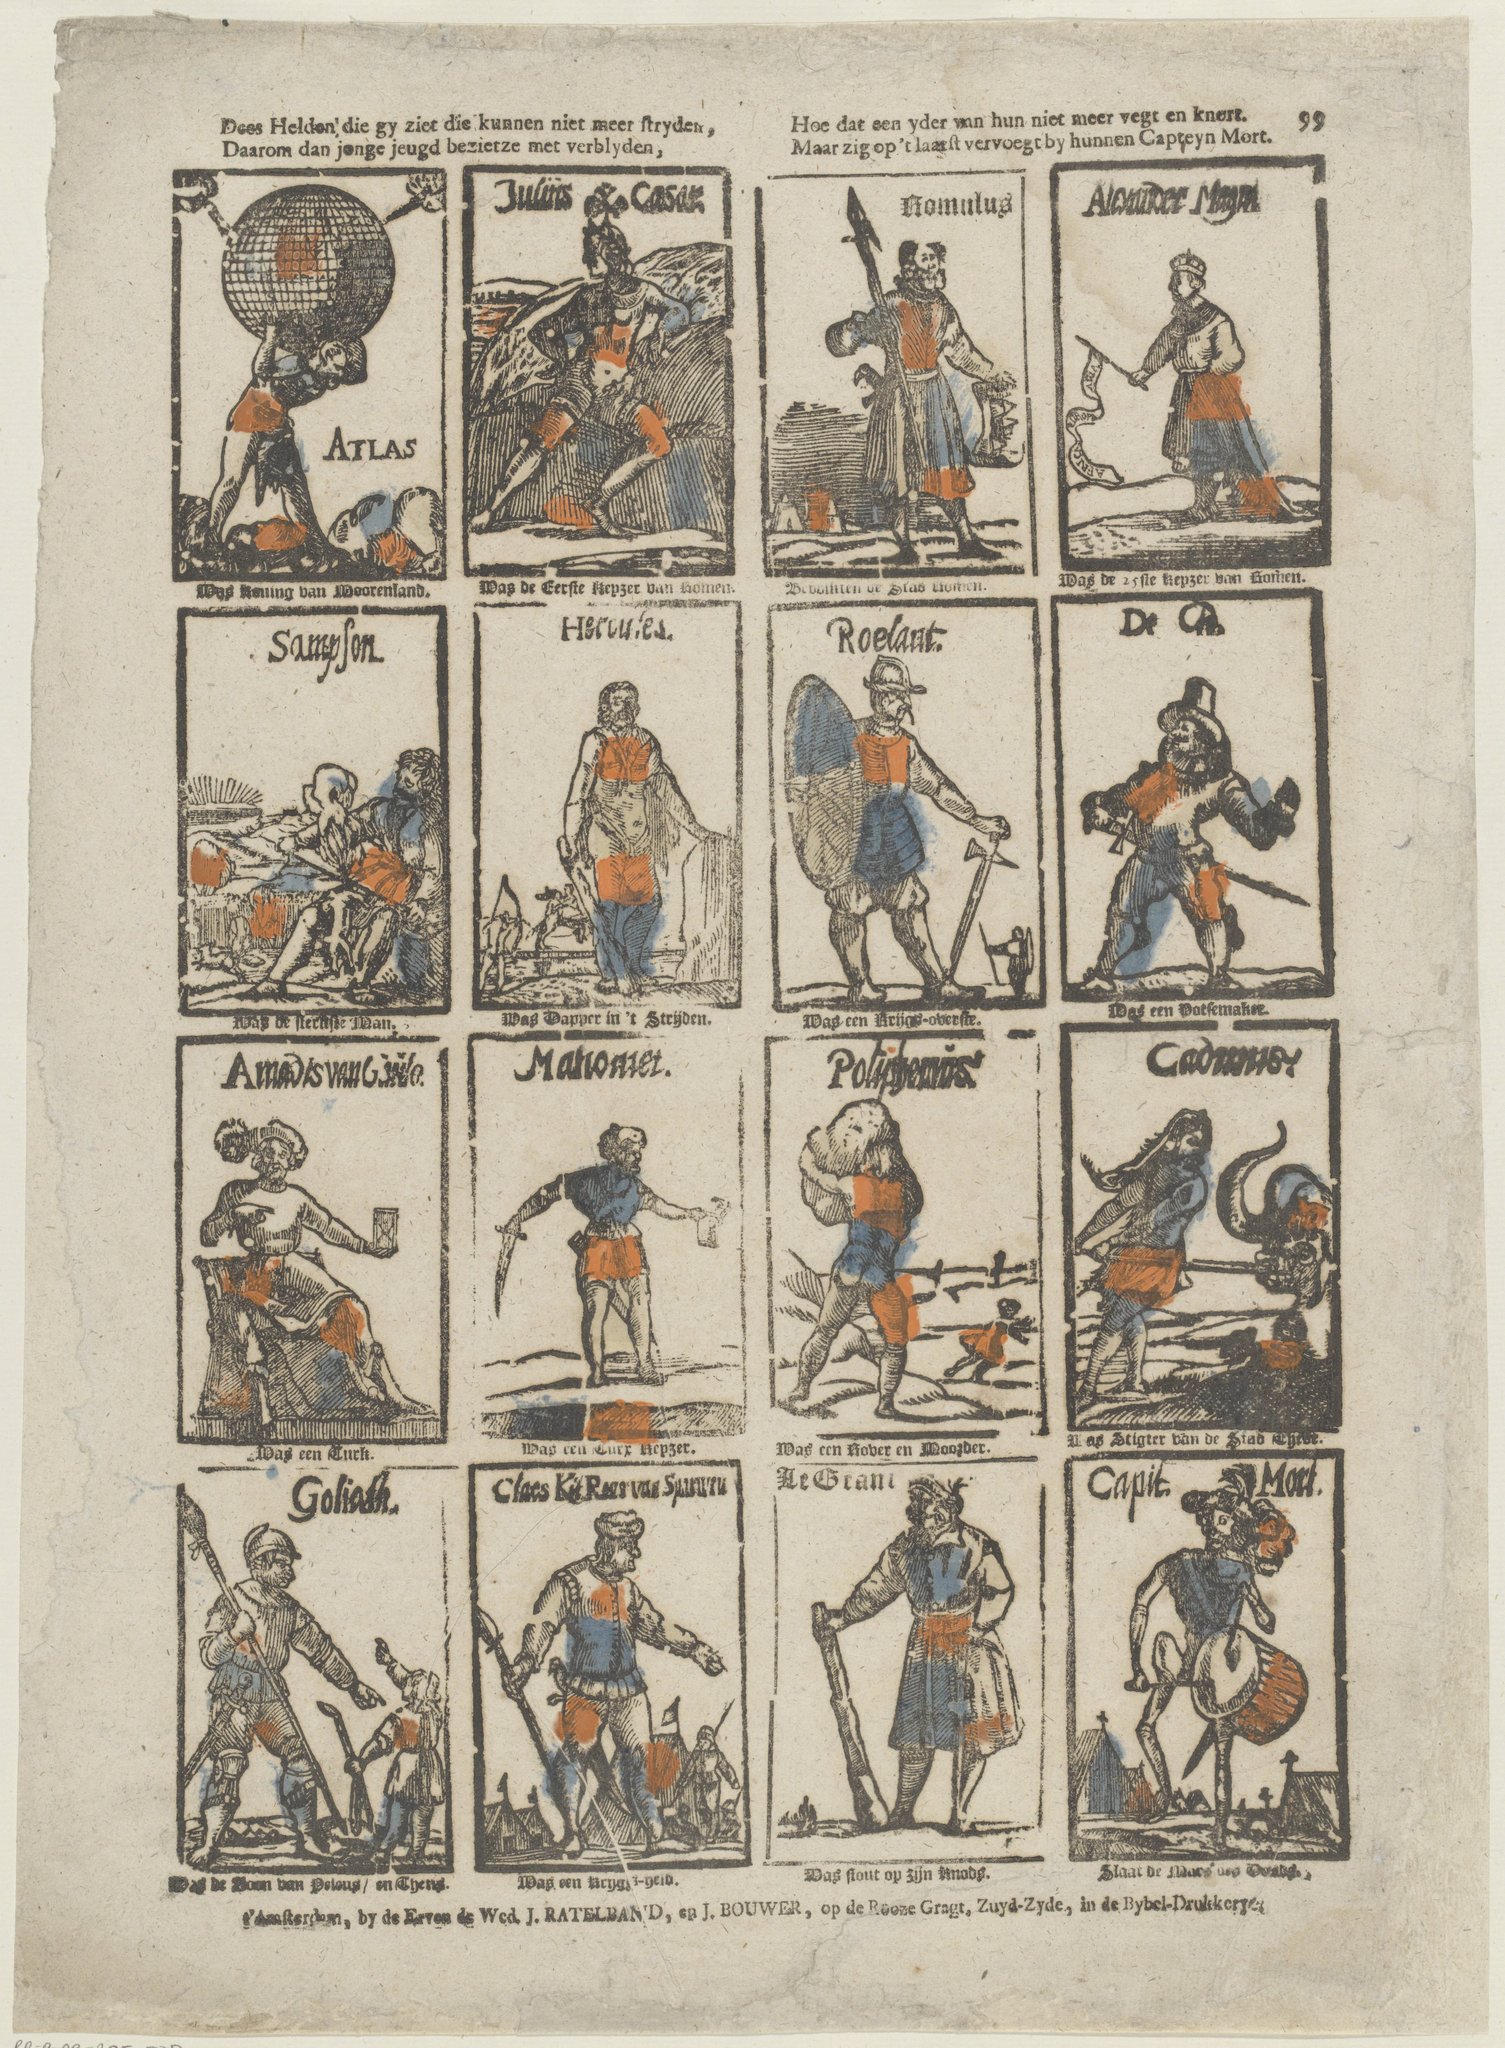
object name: print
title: Dees helden 'die gy ziet die kunnen niet meer stryden, / Daarom dan jonge jeugd bezietze met verblyden, / Hoe dan een yder van hun niet meer vegt en knort. / Maar zig op 't laatst vervoegt by hunnen Capteyn Mort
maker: Anonymous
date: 1782-1793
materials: paper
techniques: colour, letterpress printing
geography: netherlands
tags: (story of) hercules (heracles), (story of) atlas, roland, historical persons, (story of) romulus and remus, gods ~ classical mythology, samson (not in biblical context); possible attributes: broken pillar, club, jawbone, lion's head, lion's pelt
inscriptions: collector's mark: Lugt 2760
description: Blad met 16 voorstellingen van historische en mythologische figuren. Onder elke afbeelding een onderschrift in boekdruk, in elke afbeelding de naam van de figuur in houtsnede. Genummerd rechtsboven: 99.